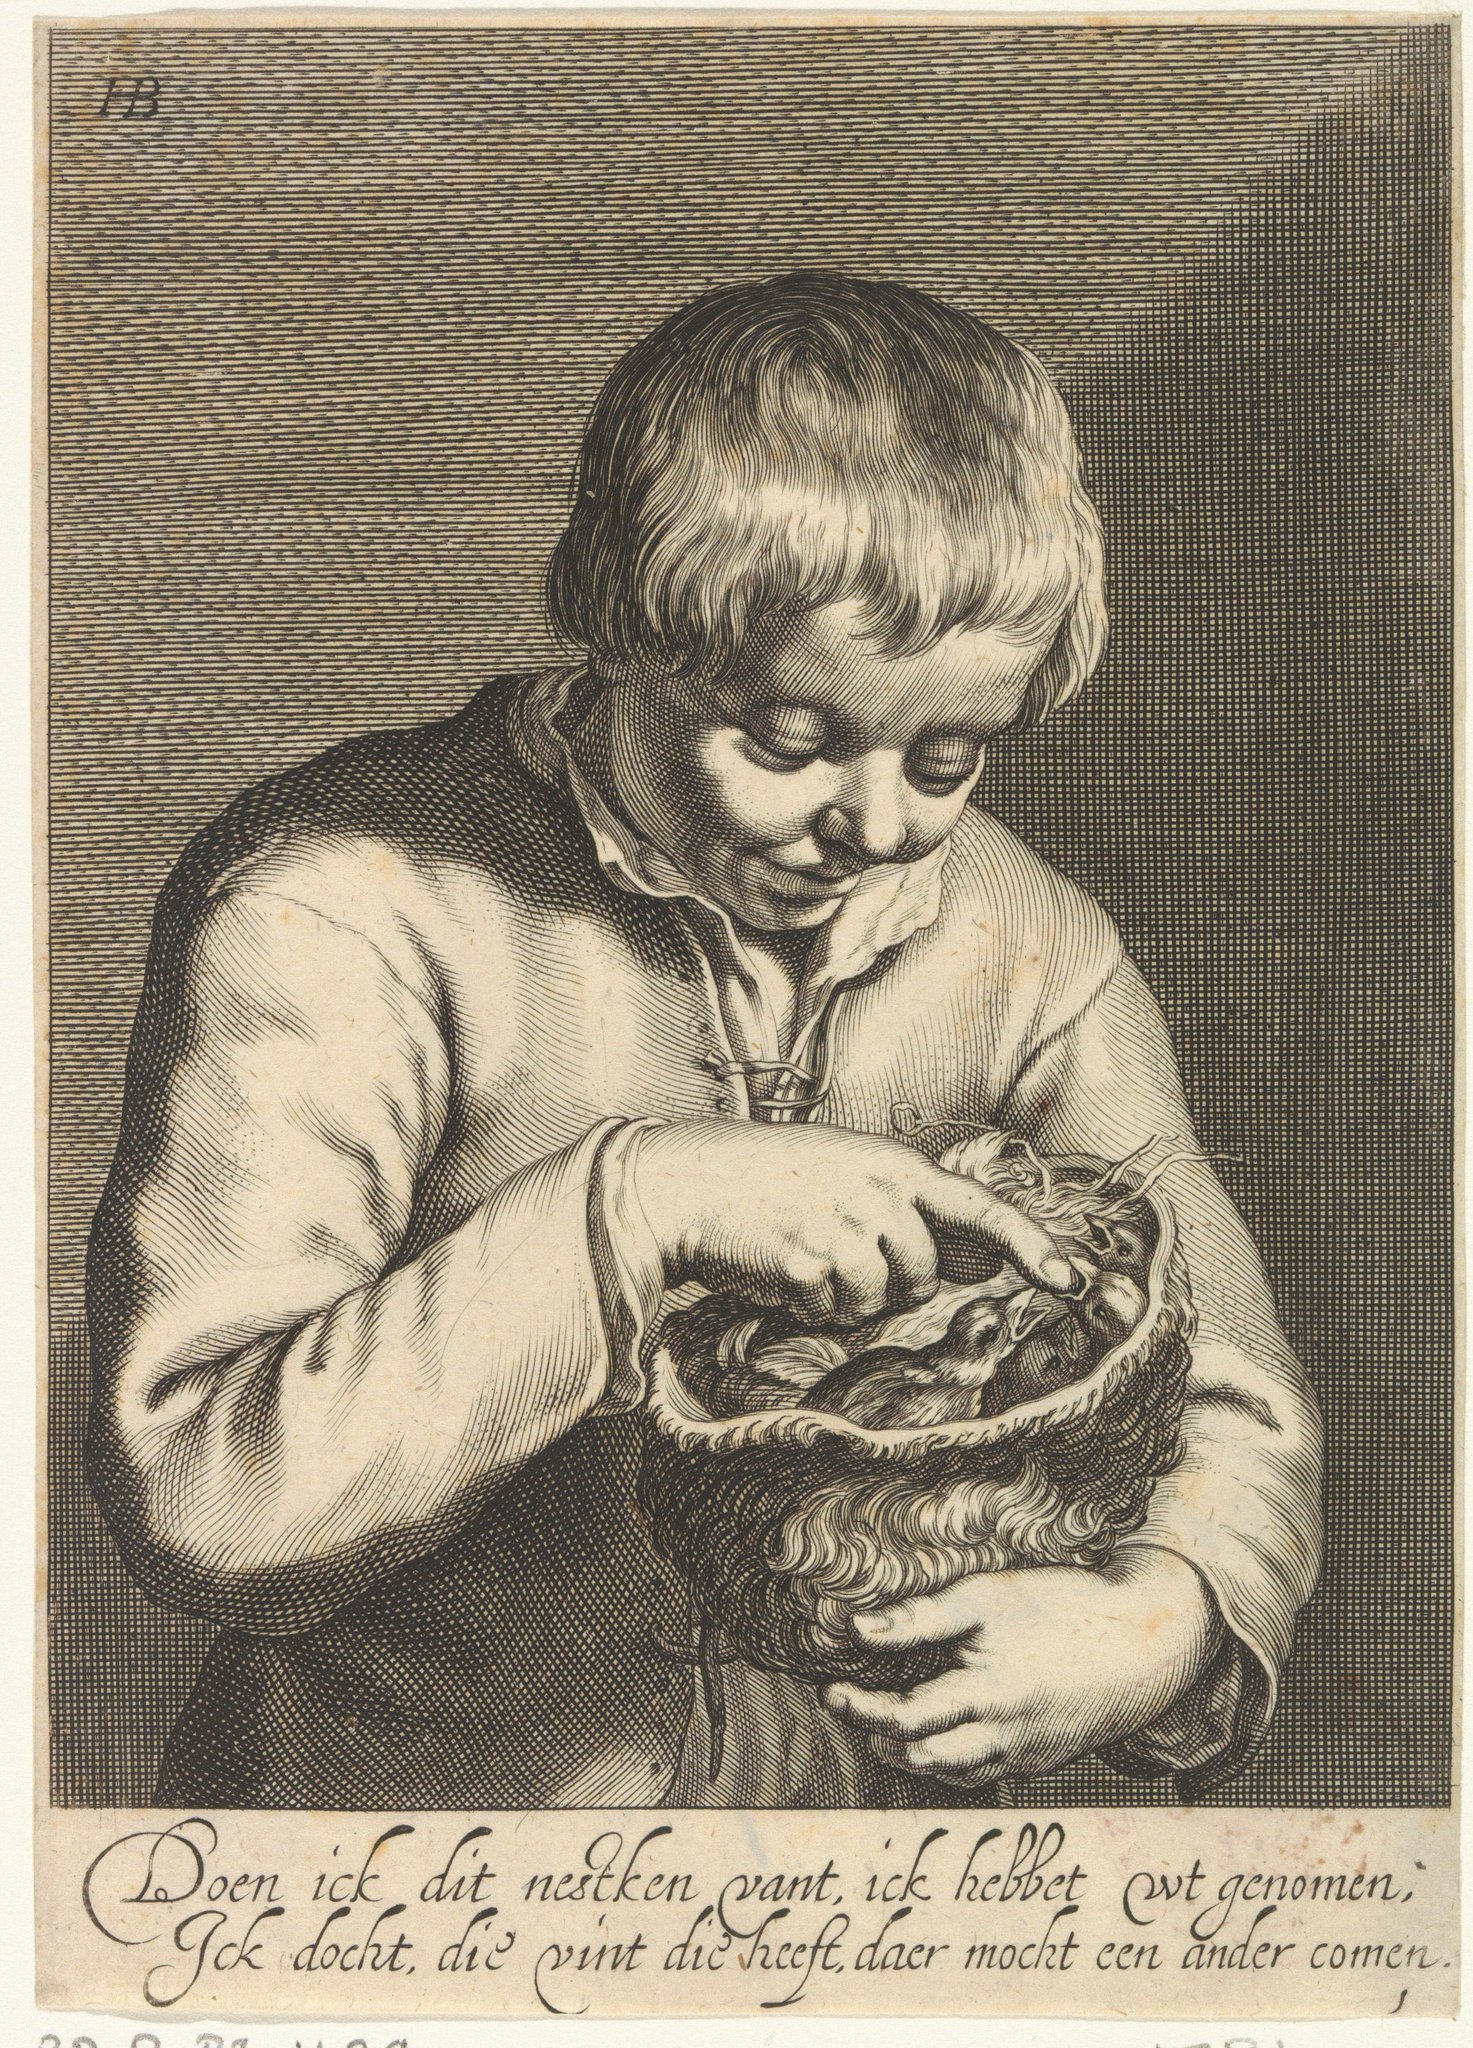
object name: print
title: Jongen met vogelnestje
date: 1625-1675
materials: paper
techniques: engraving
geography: utrecht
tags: bird in a cage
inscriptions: collector's mark: Lugt 240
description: Een jongen buigt zich over zijn hoed waarin een vogel zijn nestje heeft gebouwd. Met tweeregelig Nederlands onderschrift.